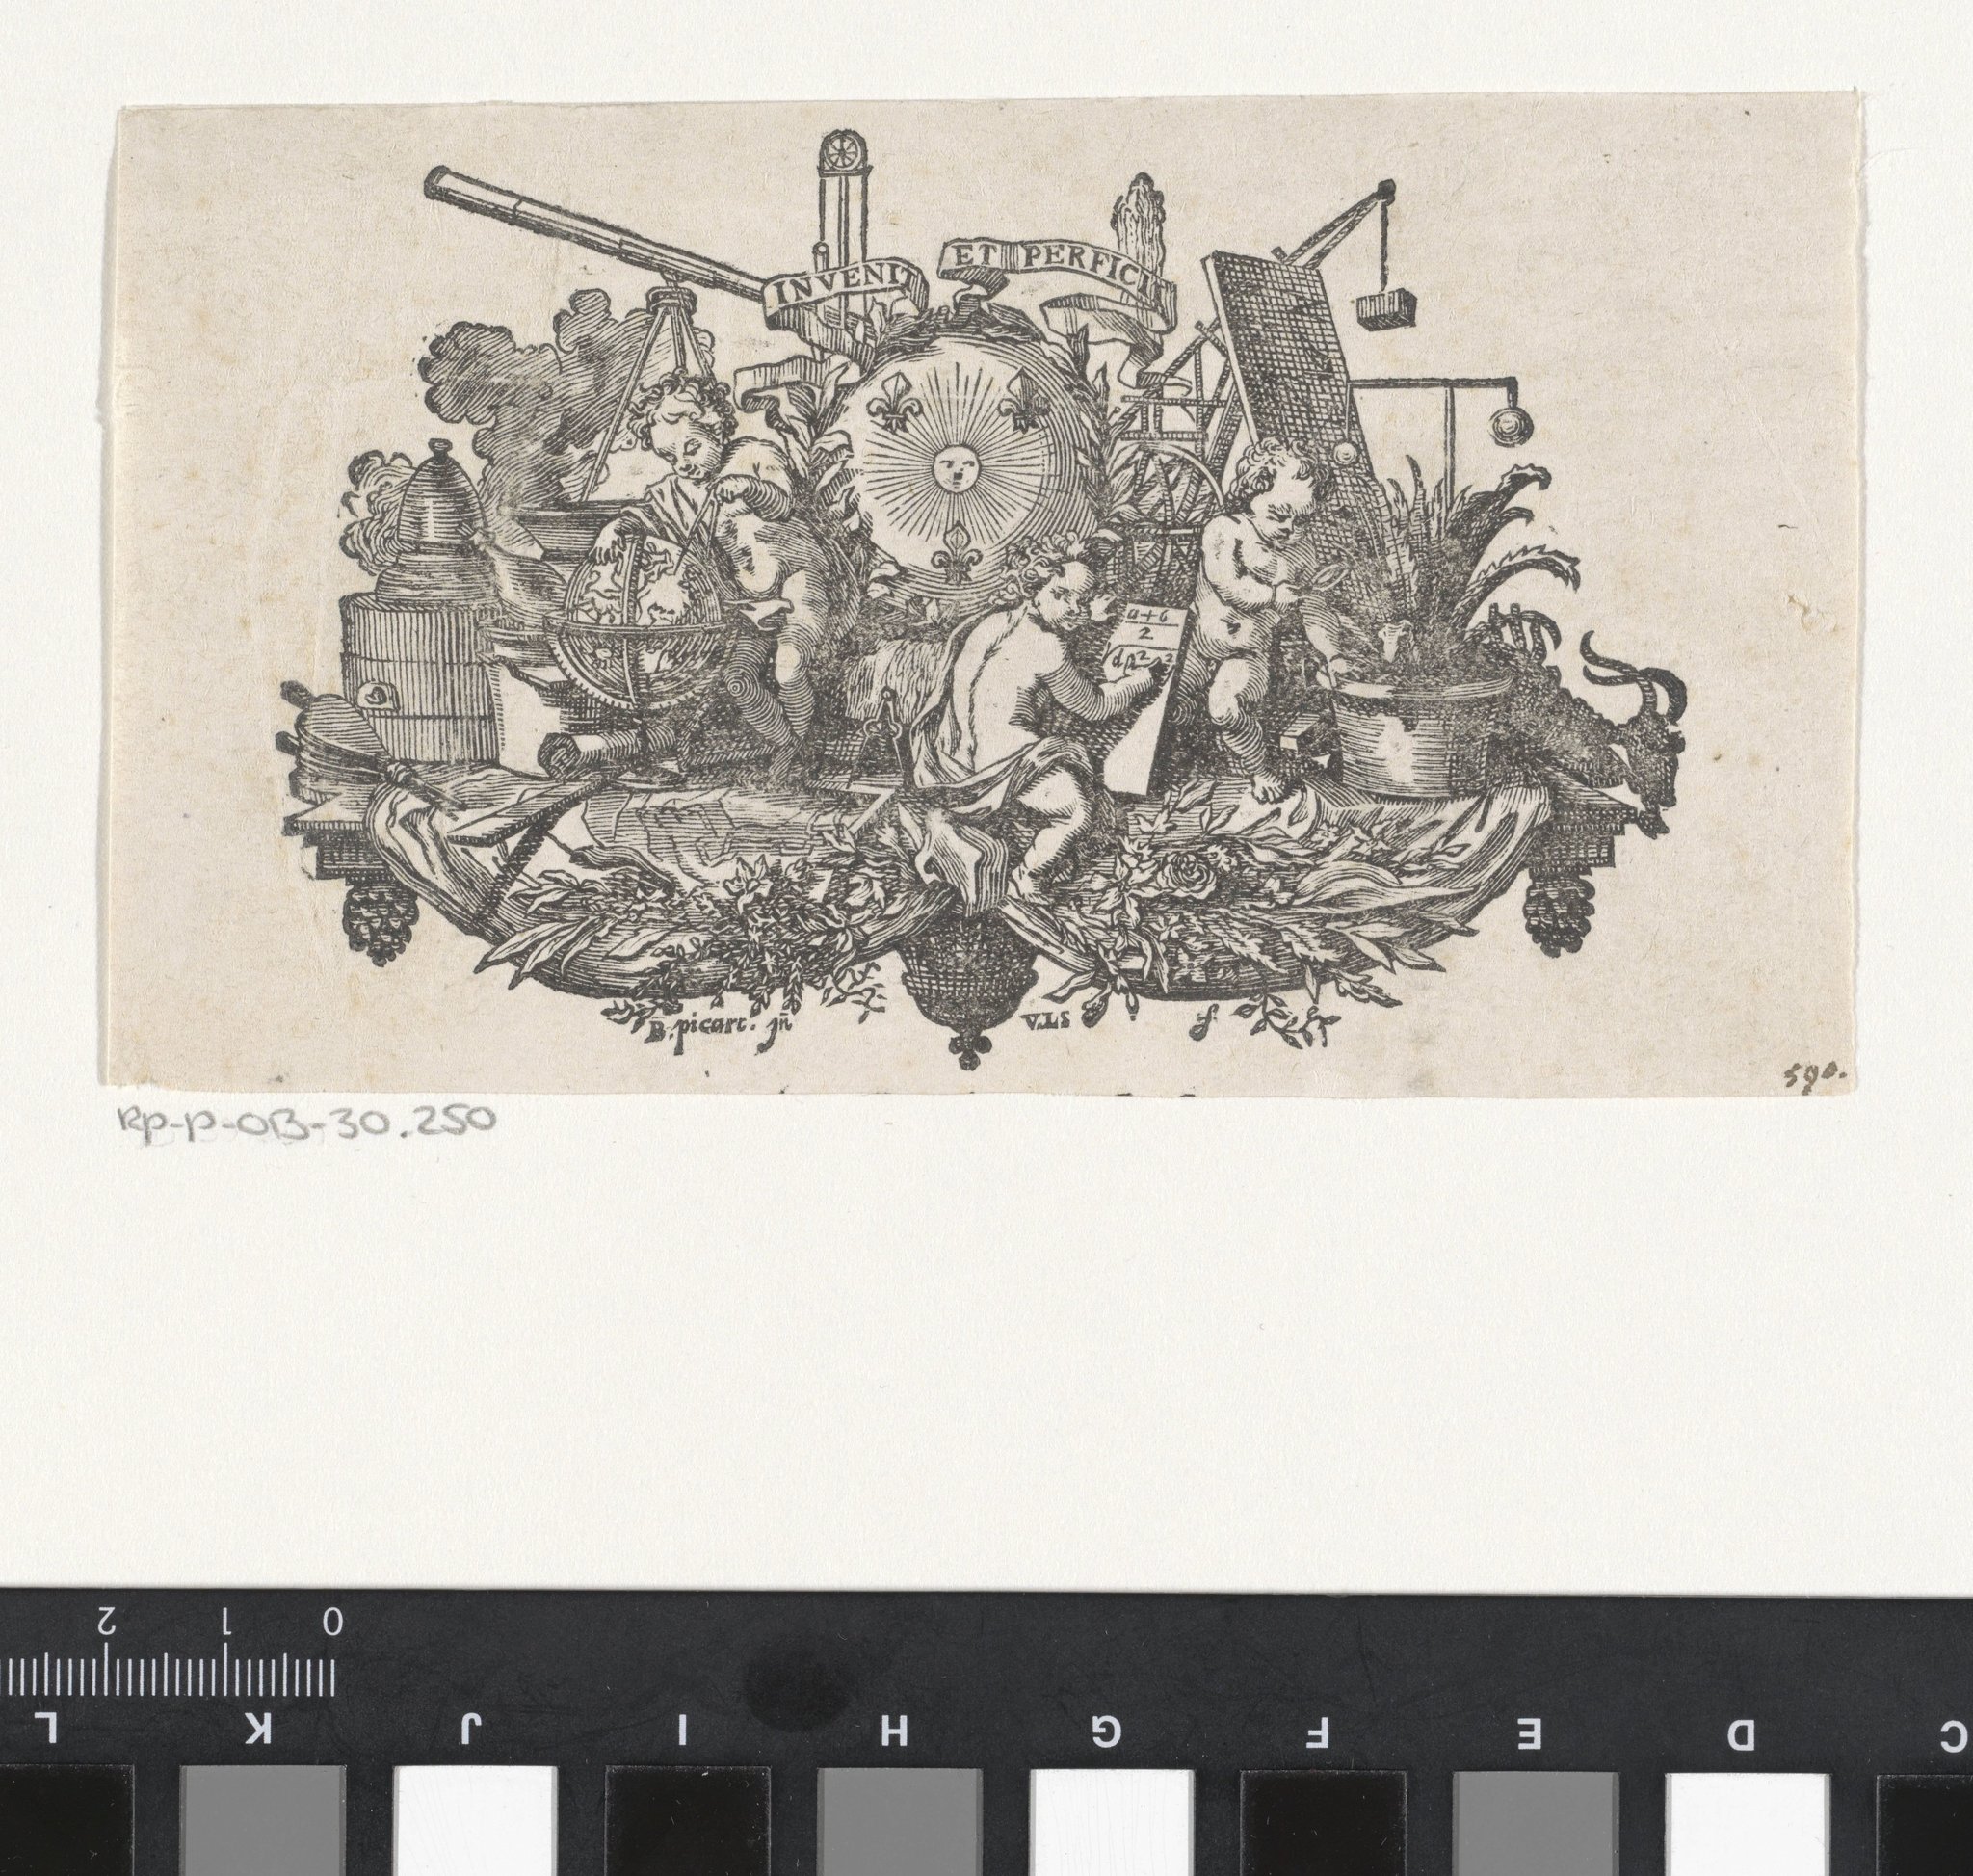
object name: print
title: Vignet met wetenschappelijke instumenten en drie putti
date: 1683-1733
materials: paper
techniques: woodcut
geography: netherlands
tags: aspects of science in general (+ tools, instruments; laboratory equipment ~ scientific research), vignette, cupids: 'amores', 'amoretti', 'putti'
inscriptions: collector's mark: Lugt 2228